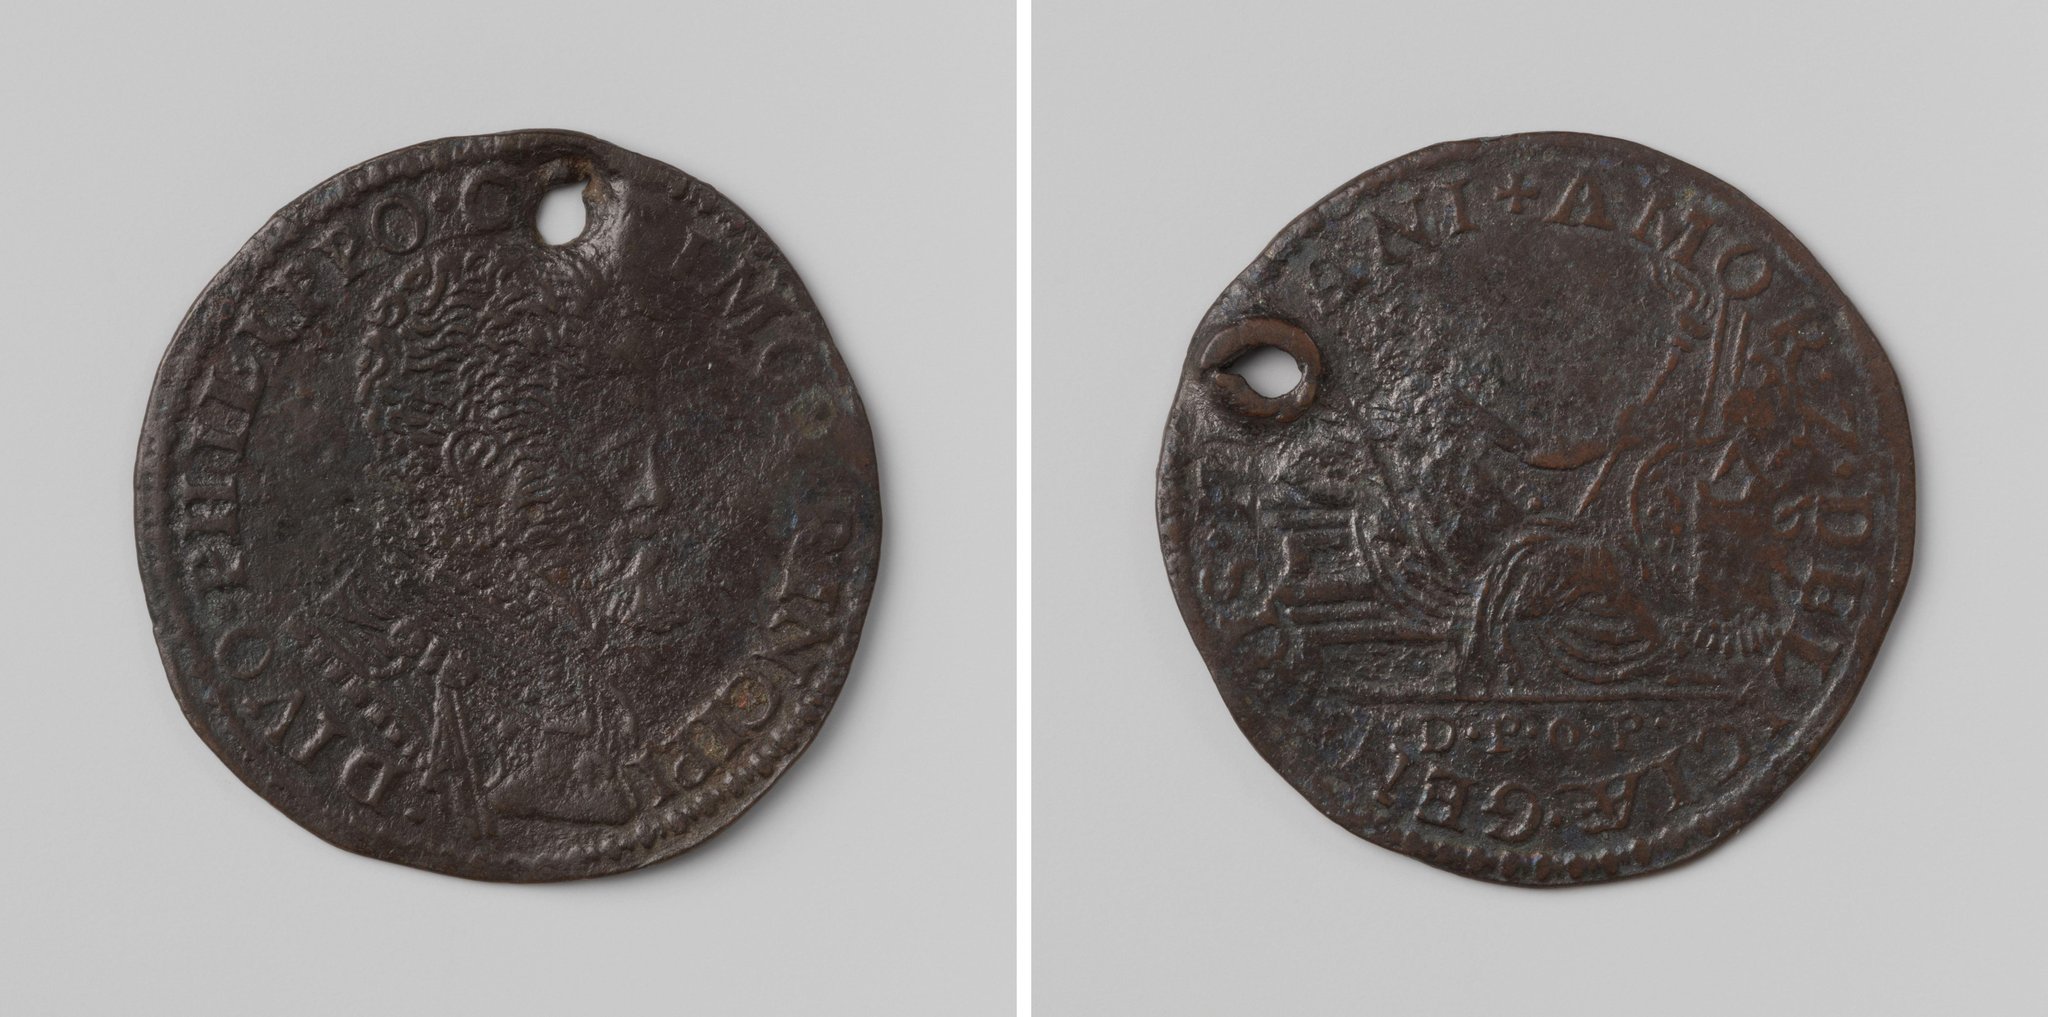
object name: jeton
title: Filips, erfprins van Spanje, heer der Nederlanden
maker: Anonymous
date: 1555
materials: copper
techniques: striking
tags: philip ii of spain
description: Koperen penning met gat erin. Voorzijde: borststuk man binnen omschrift. Keerzijde: vrouw met palmtak in rechter- en brandende fakkel in linkerhand zittend naast zegeteken binnen omschrift; afsnede: opschrift